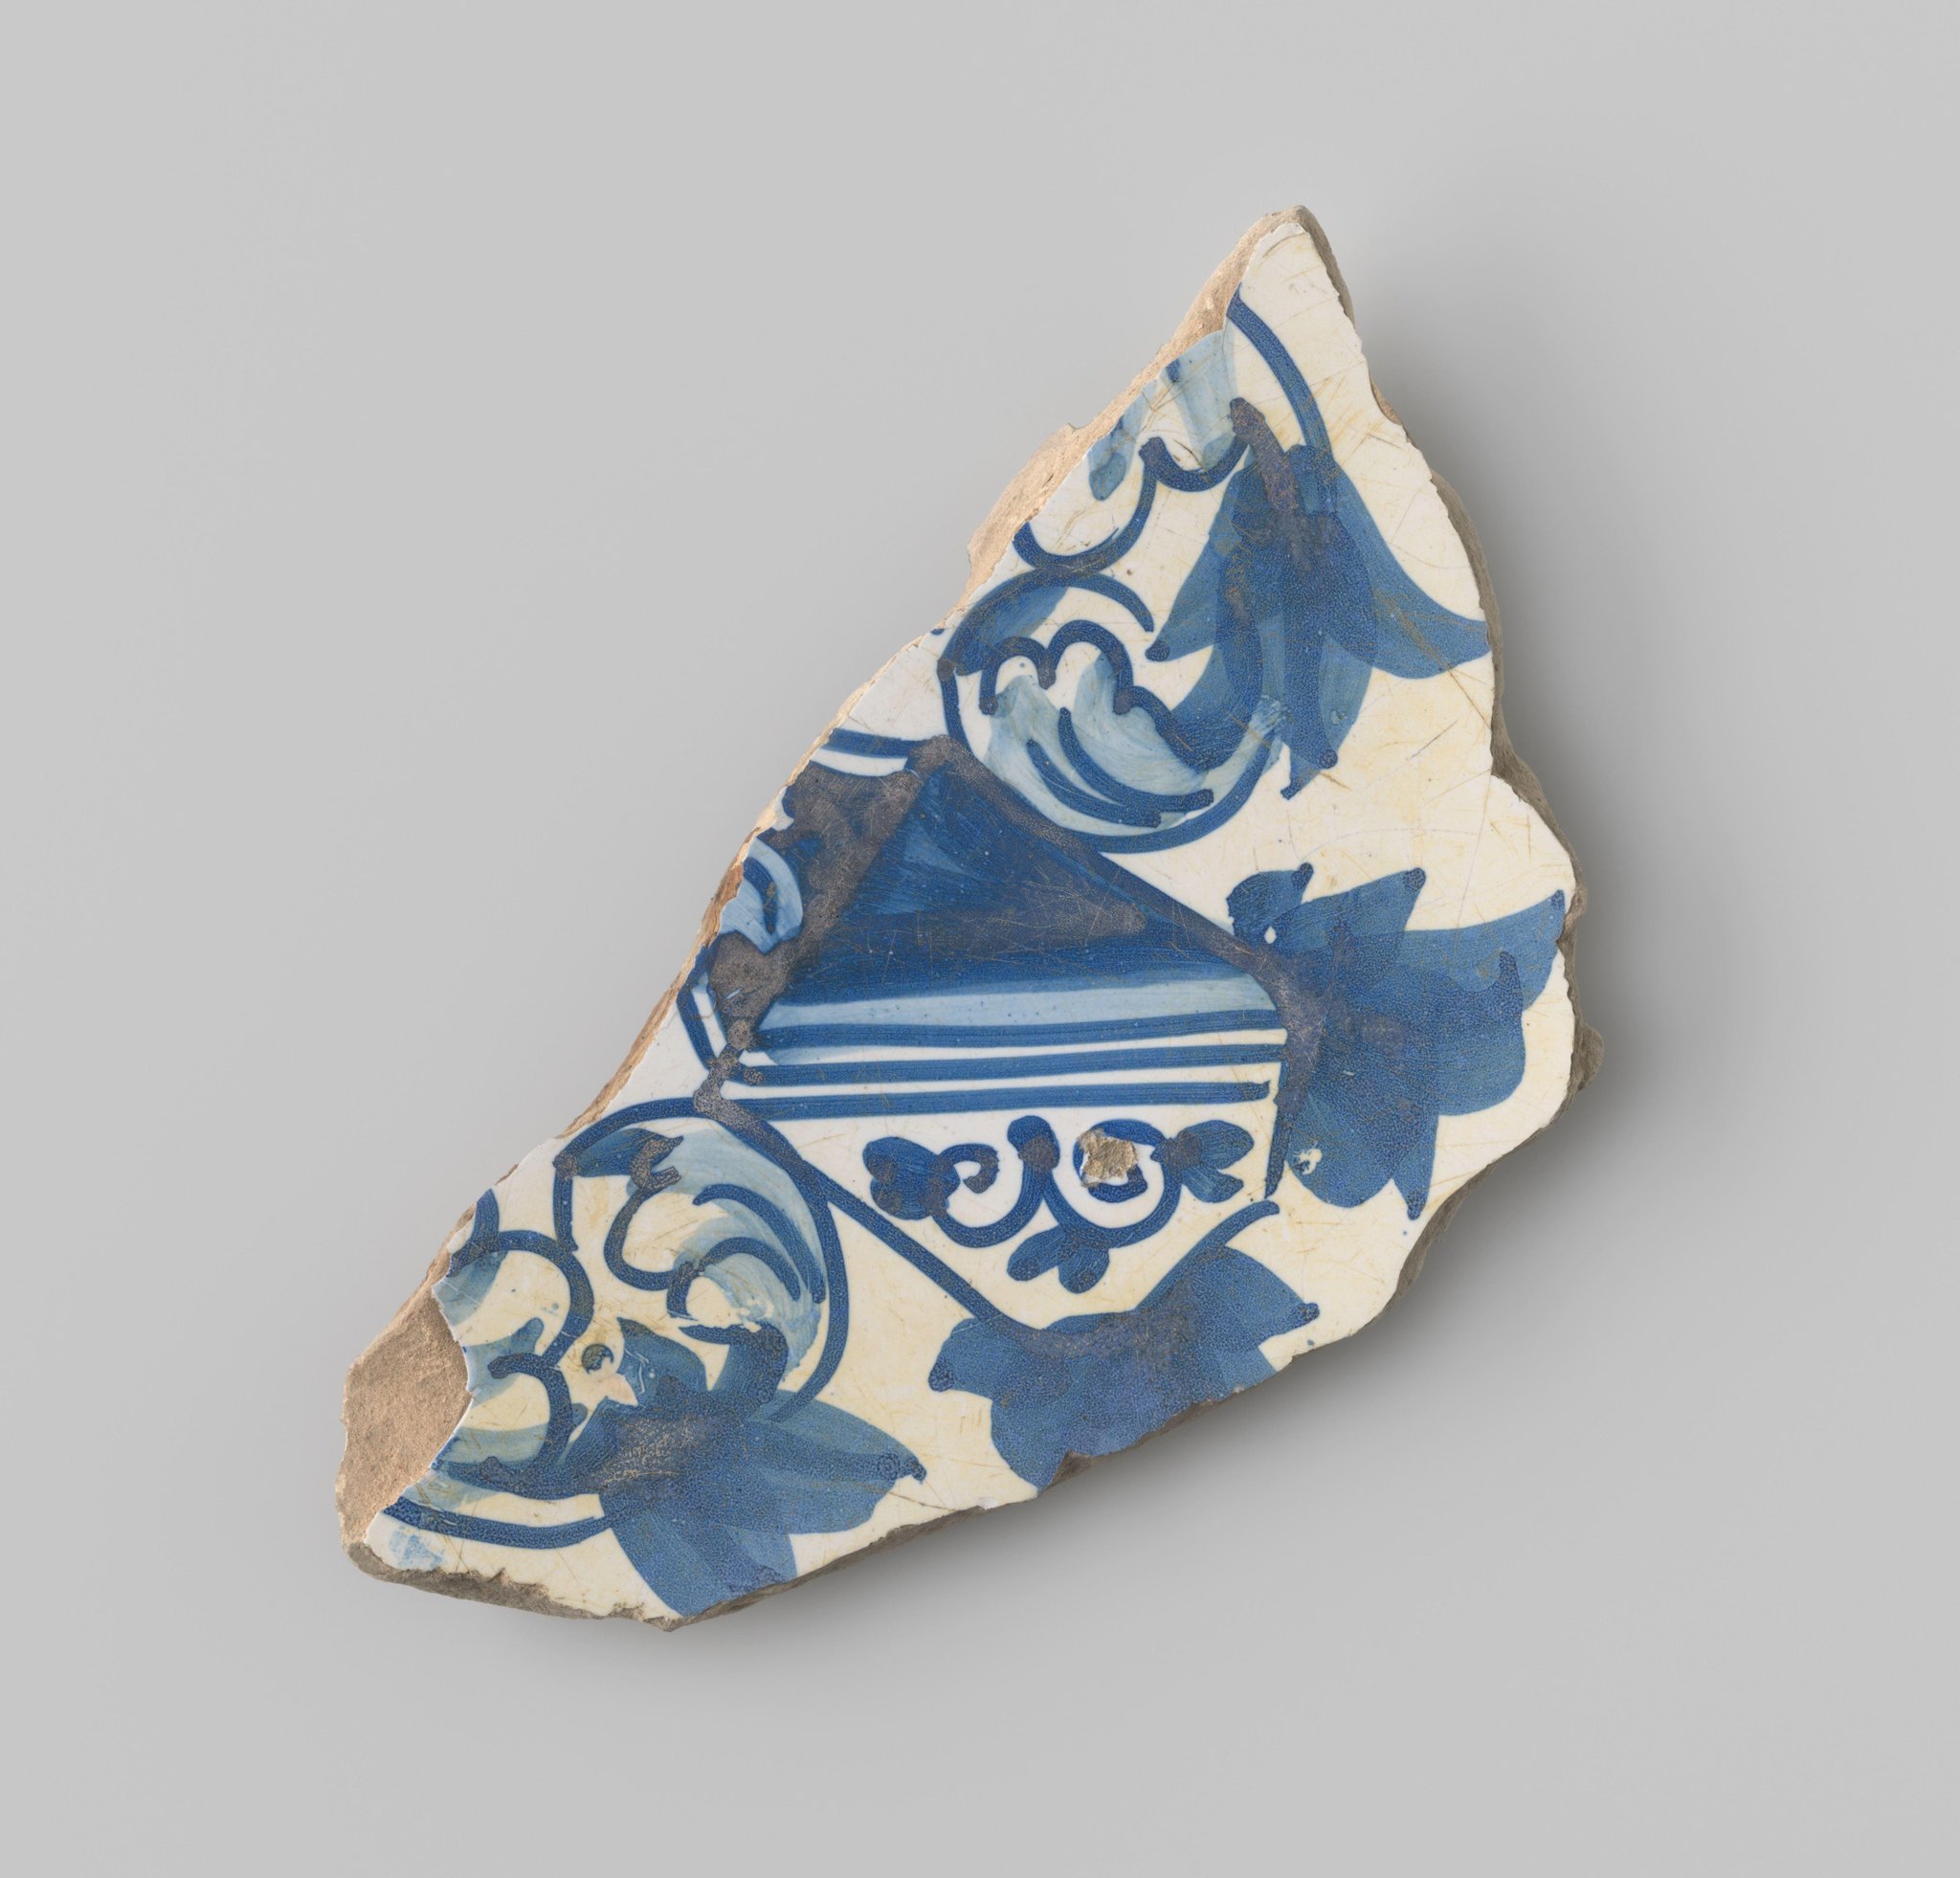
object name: fragment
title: Schotelscherf van witbakkend aardewerk, voorzien van wit glazuur aan de bovenzijde, waarop een deel van een wapen met pluimen in blauw geschilderd is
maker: Anonymous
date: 1500-1699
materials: earthenware, glaze